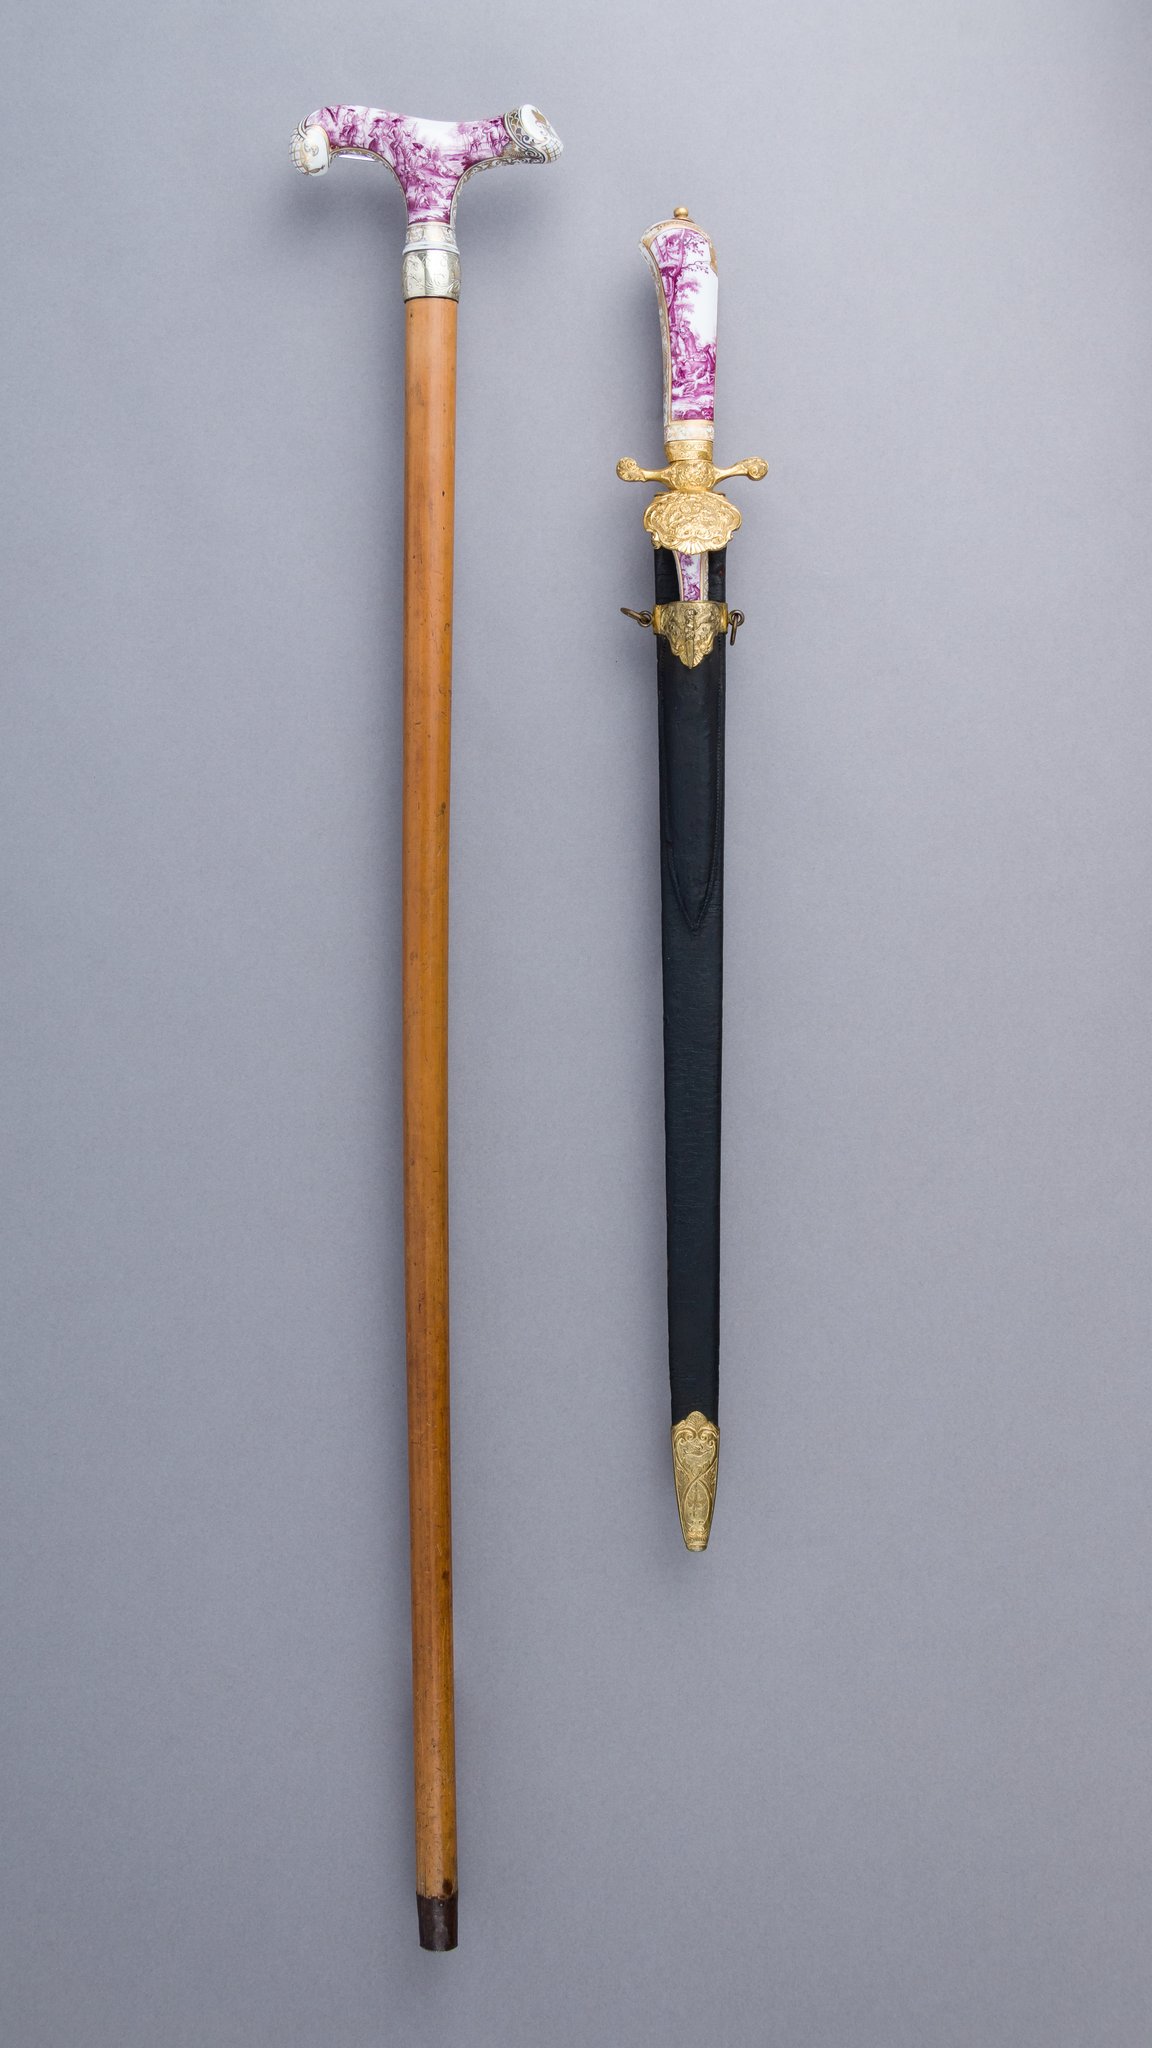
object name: walking stick with companion hunting sword, knife, and scabbard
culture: german or austrian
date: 1780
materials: copper alloy, gold, leather, porcelain, silver, steel, wood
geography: germany